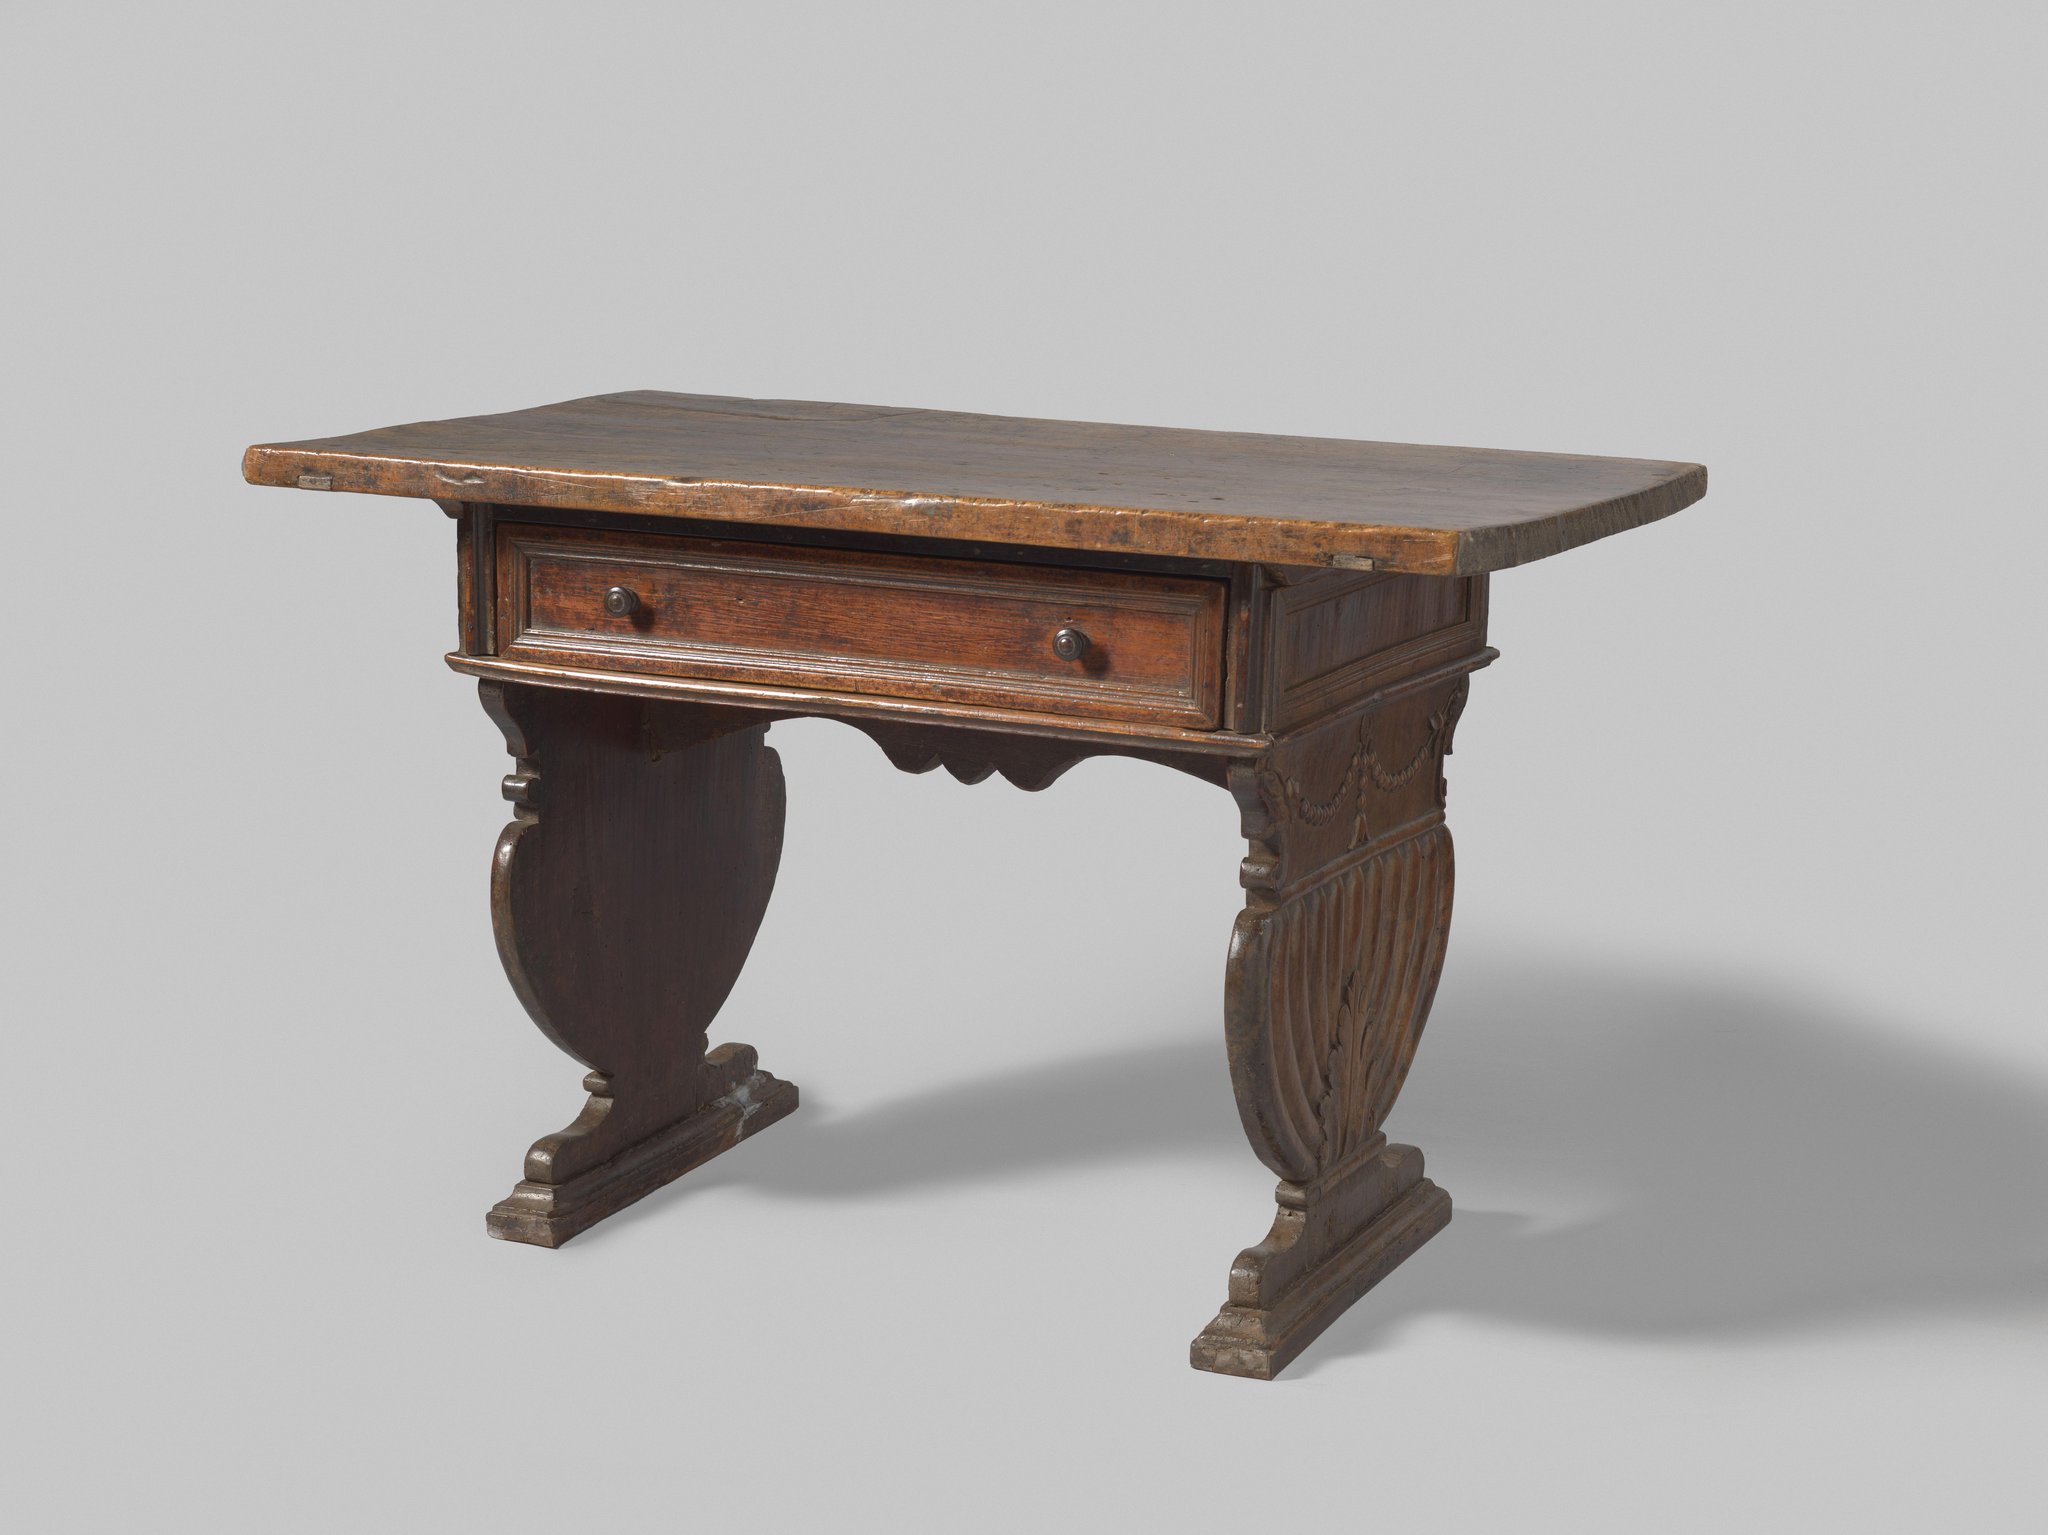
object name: wangtafel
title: Wangentafel met vaasvormige wangen met toegewende knorren en staand acanthusblad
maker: Anonymous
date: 1500-1600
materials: wood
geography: italy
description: Wangentafel van notenhout. De wangen zijn vaasvormig en versierd met toegewende knorren, met in het midden een staand acanthusblad. Hierboven op gezande grond een aan een ring opgehangen kralenketen, in kelken eindigend. De regel heeft geprofileerde velden en aan de voorzijde een schuiflade met twee gedraaide knoppen. Het blad sluit met klampen over de zijregels. De wangen zijn onder de regels door een, aan de onderzijde geschulpte, sport verbonden.